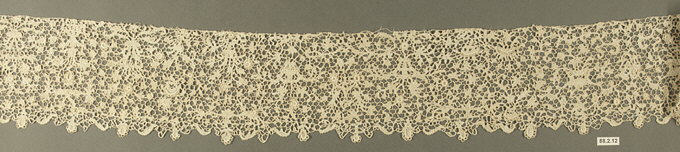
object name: border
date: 1701-1800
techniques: lace